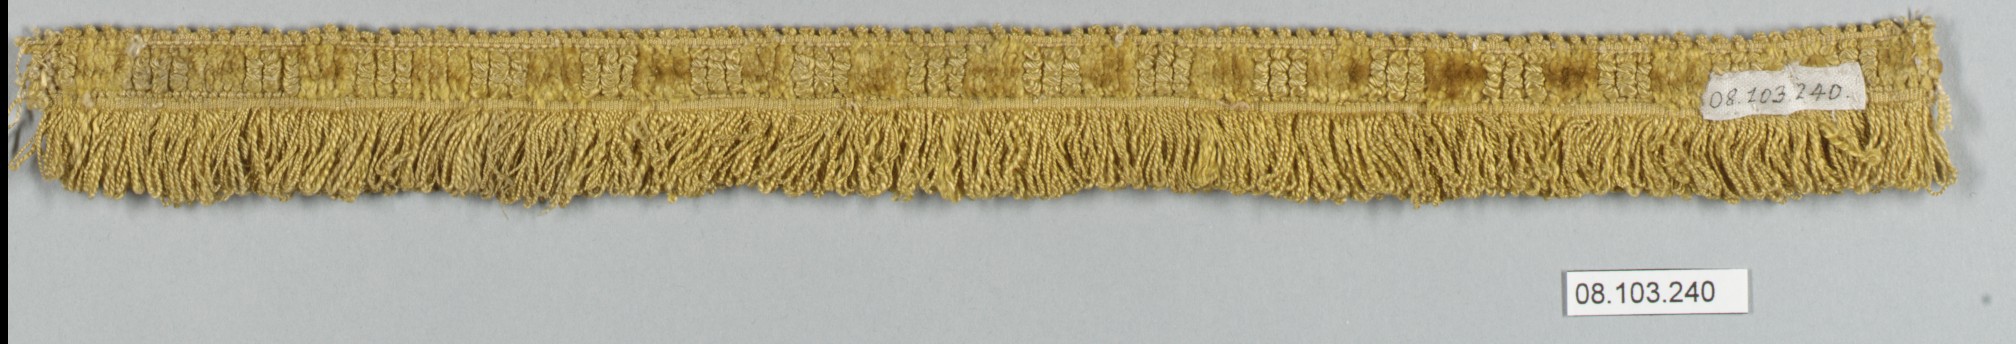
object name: gimp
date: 1601-1700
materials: silk